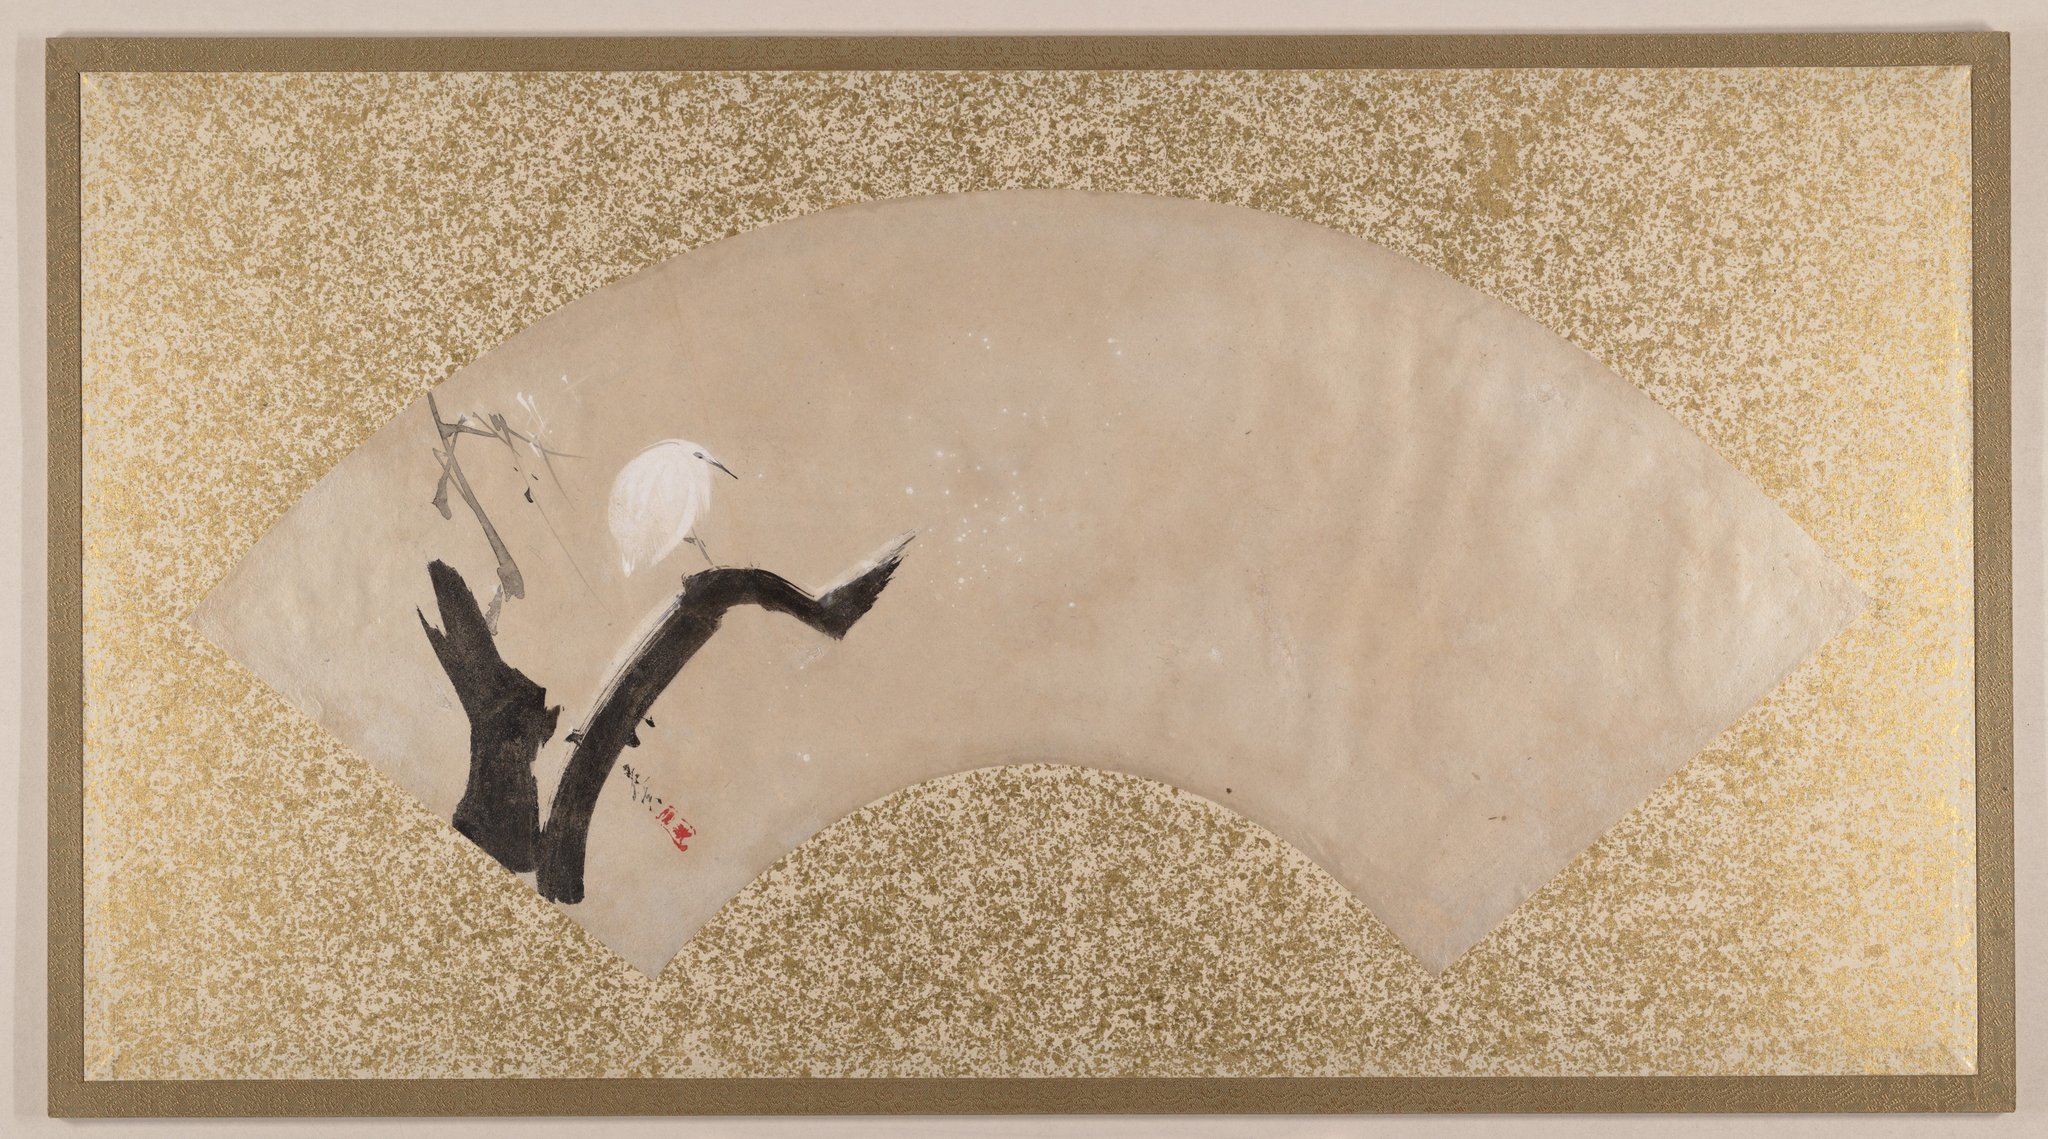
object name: album leaf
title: Egret on Tree Stump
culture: japanese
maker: shibata zeshin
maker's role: artist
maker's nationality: japanese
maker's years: 1807-1891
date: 1867-1900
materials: paper, paint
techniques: painting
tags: birds